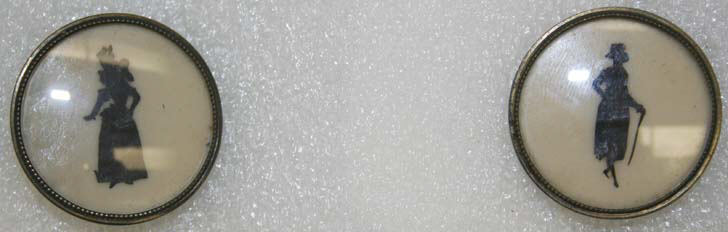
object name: button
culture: french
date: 1815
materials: metal, paper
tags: women